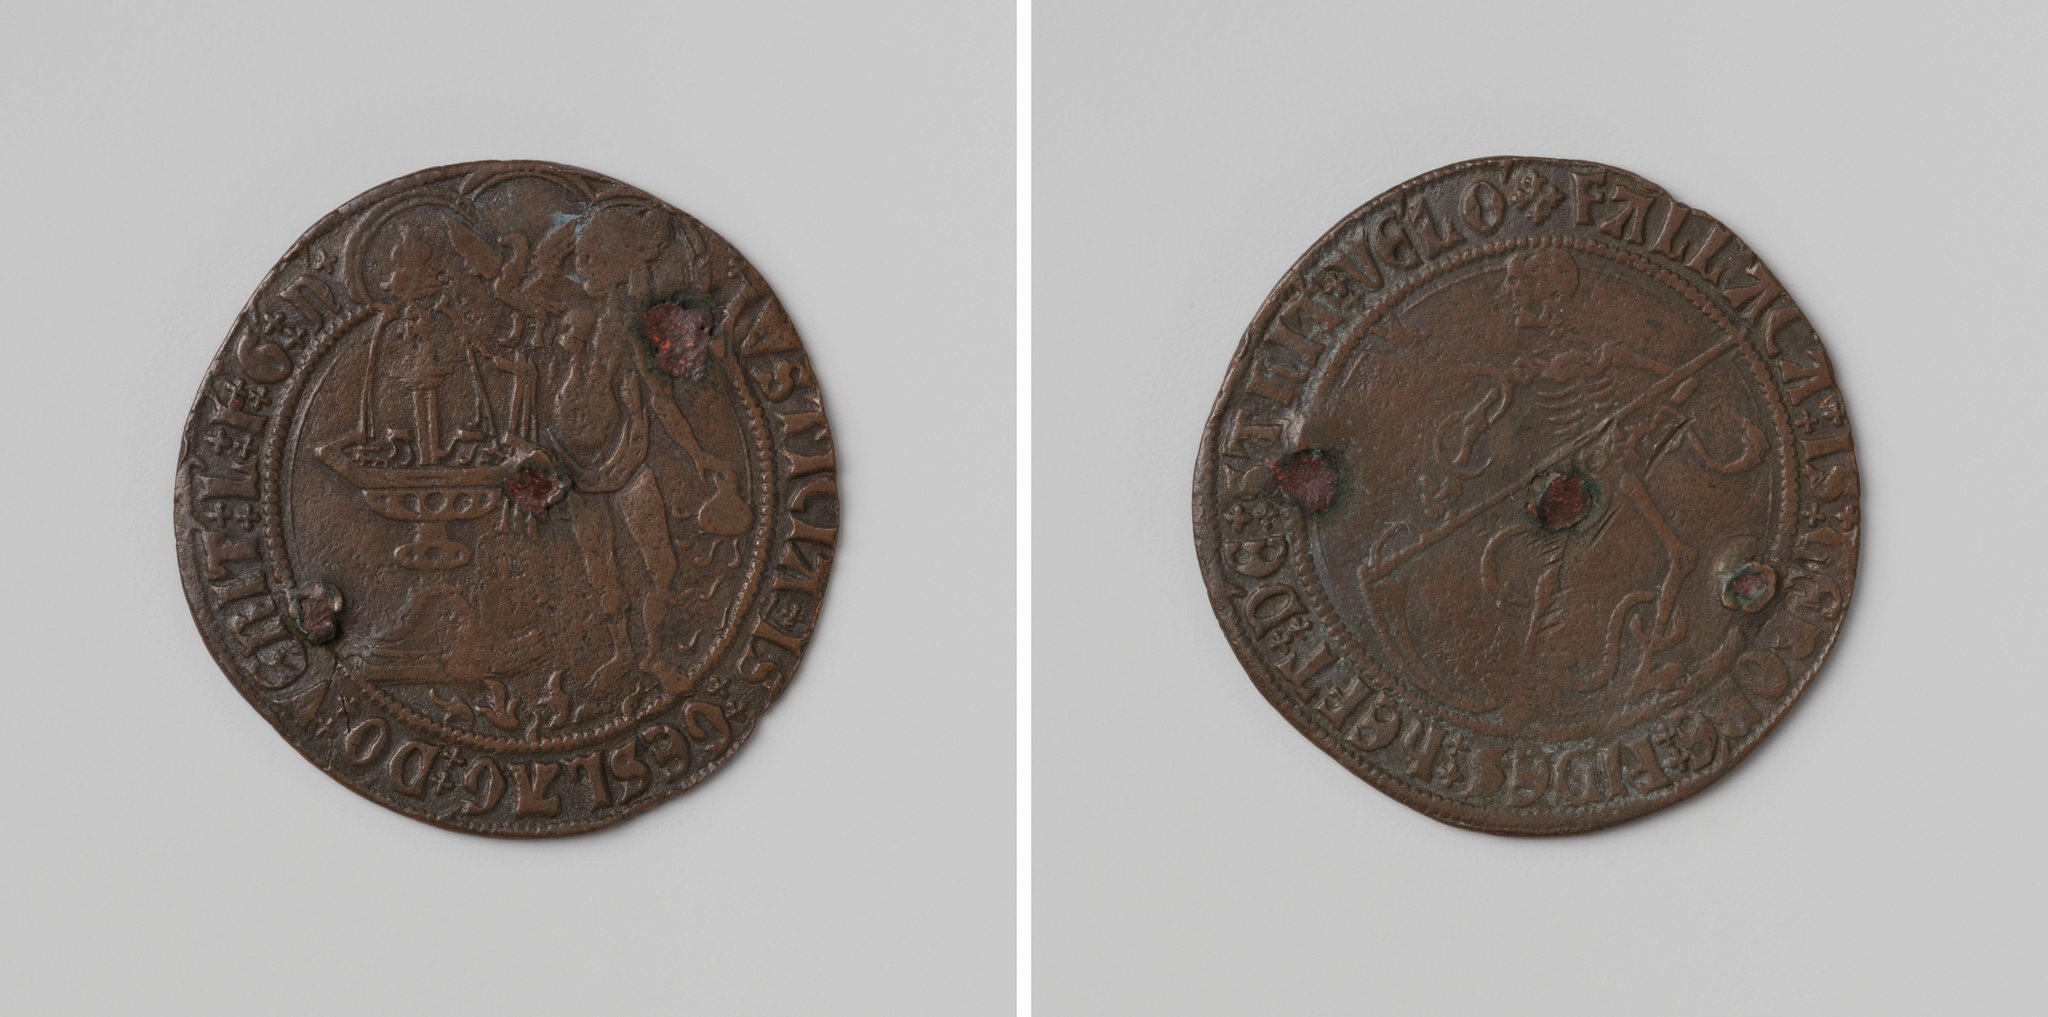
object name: jeton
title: Allegorie op het slechte bewind van Maximiliaan, aartshertog van Oostenrijk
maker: Anonymous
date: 1488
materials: copper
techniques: striking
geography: netherlands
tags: maximilian i (holy roman emperor)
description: Koperen penning. Voorzijde: vrouw met vogel in rechterhand en vuurslag, waar vonken uit schieten in linkerhand, staande naast fontein binnen omschrift. Keerzijde: Dood met zeis in hand; om hem heen vier slangen binnen omschrift